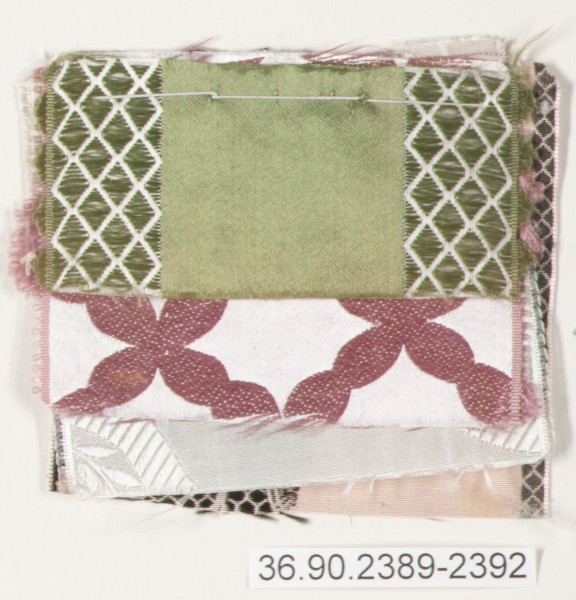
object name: ribbon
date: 1801-1900